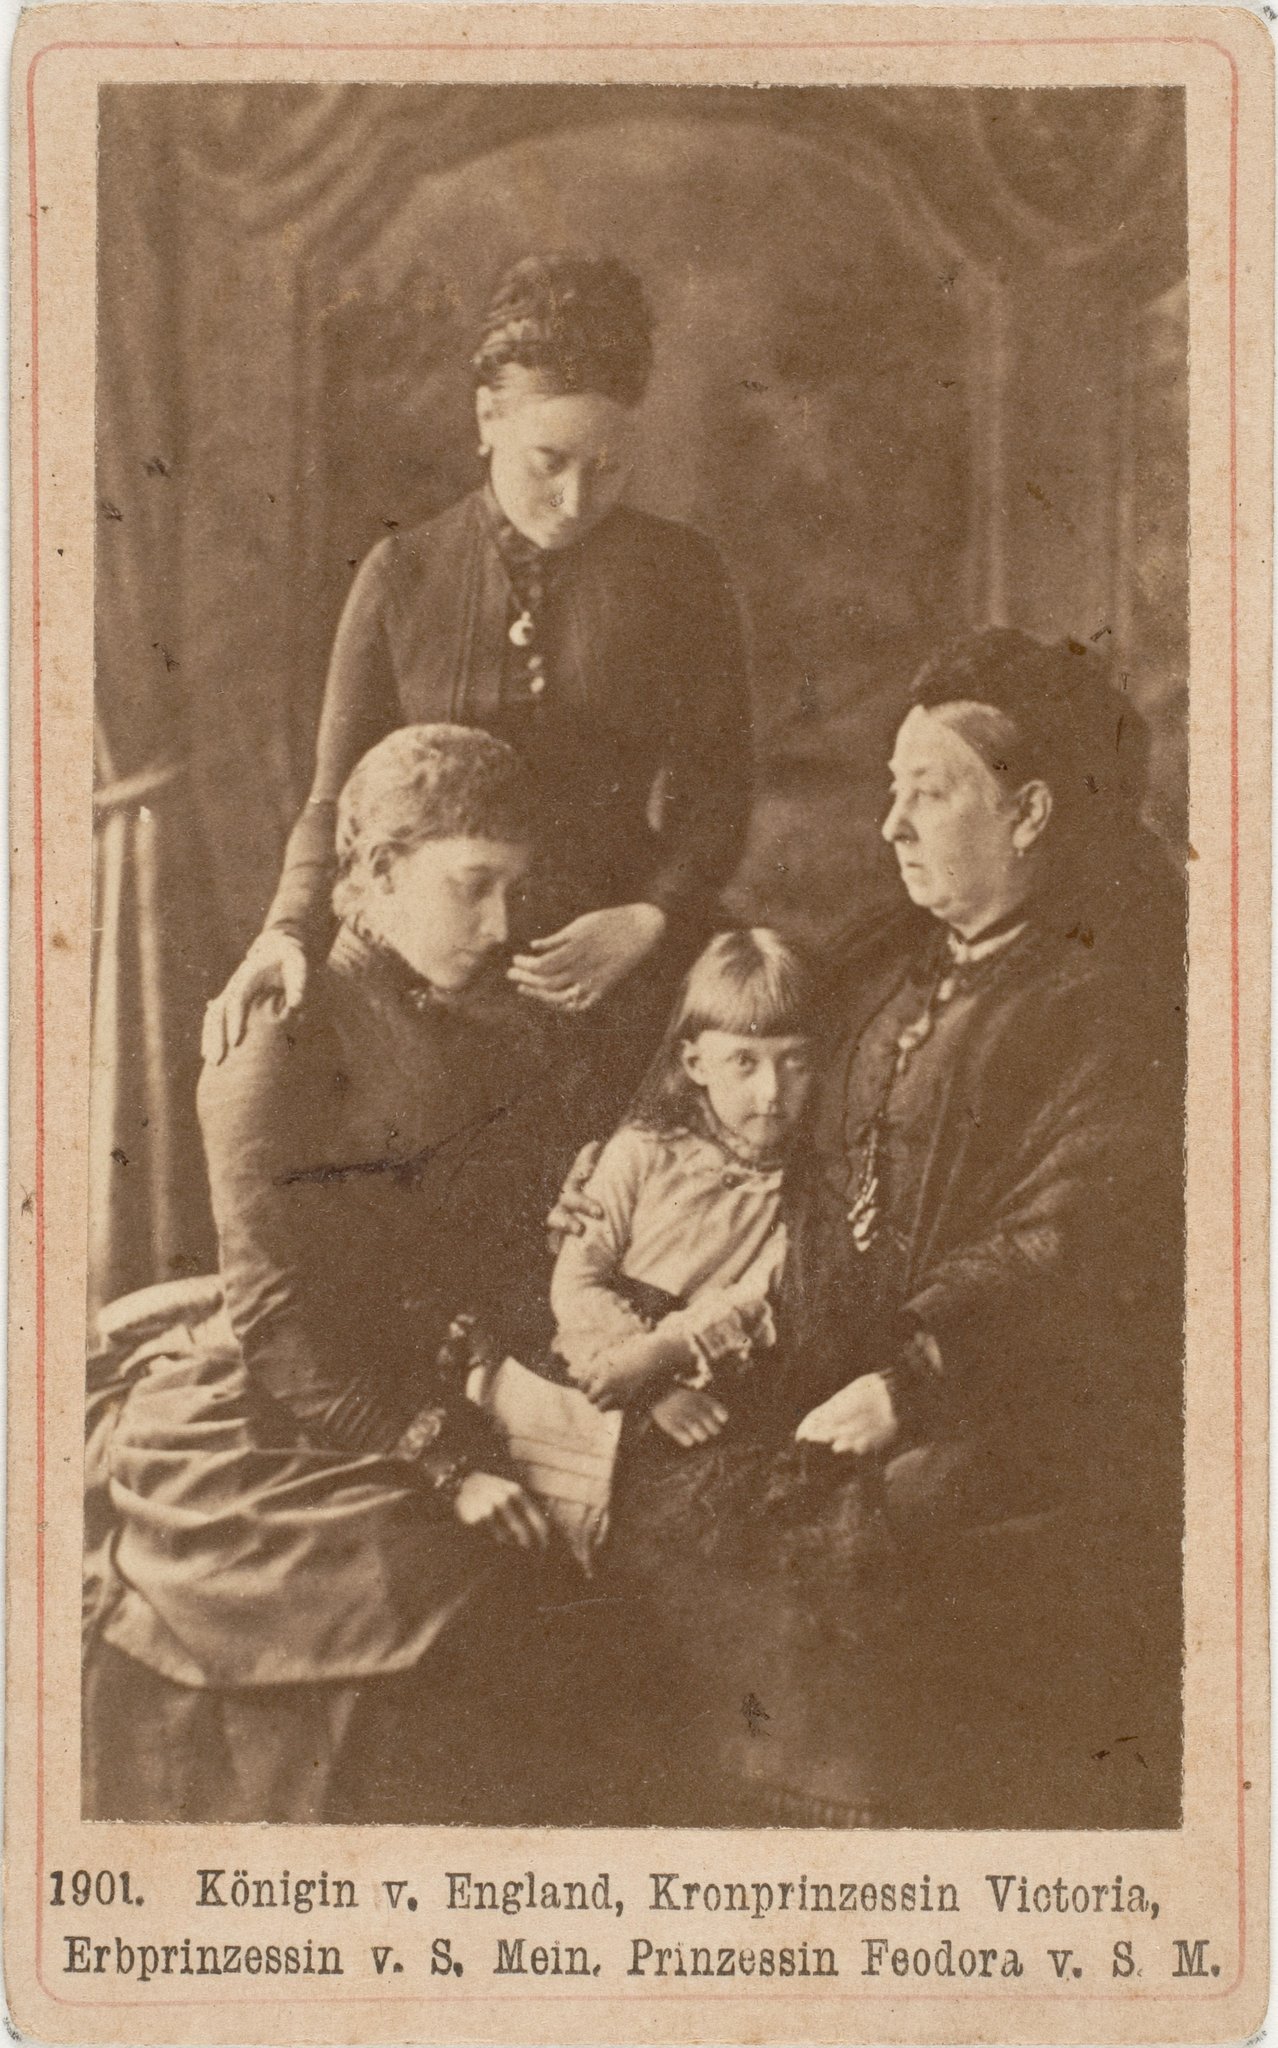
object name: photograph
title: Königin v. England, Kronprinzessin Victoria, Erbprinzessin v. S. Mein, Prinzessin Feodora v. S. M.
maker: Anonymous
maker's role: artist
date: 1860-1869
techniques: albumen silver print, glass negative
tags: princesses,children,portraits,women,queen victoria